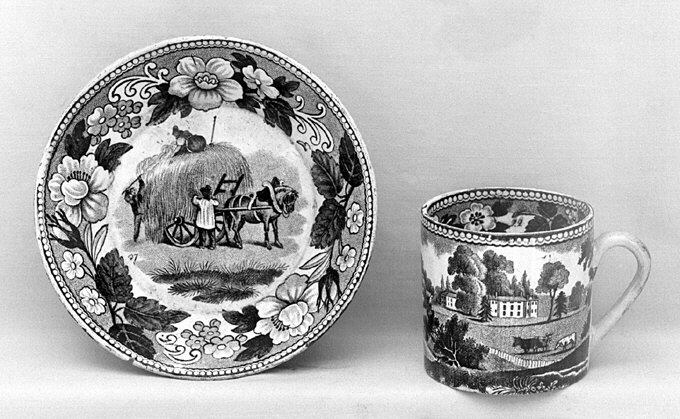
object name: saucer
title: Saucer (part of a set)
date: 1815-1830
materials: porcelain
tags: human figures,horses,flowers,carriages